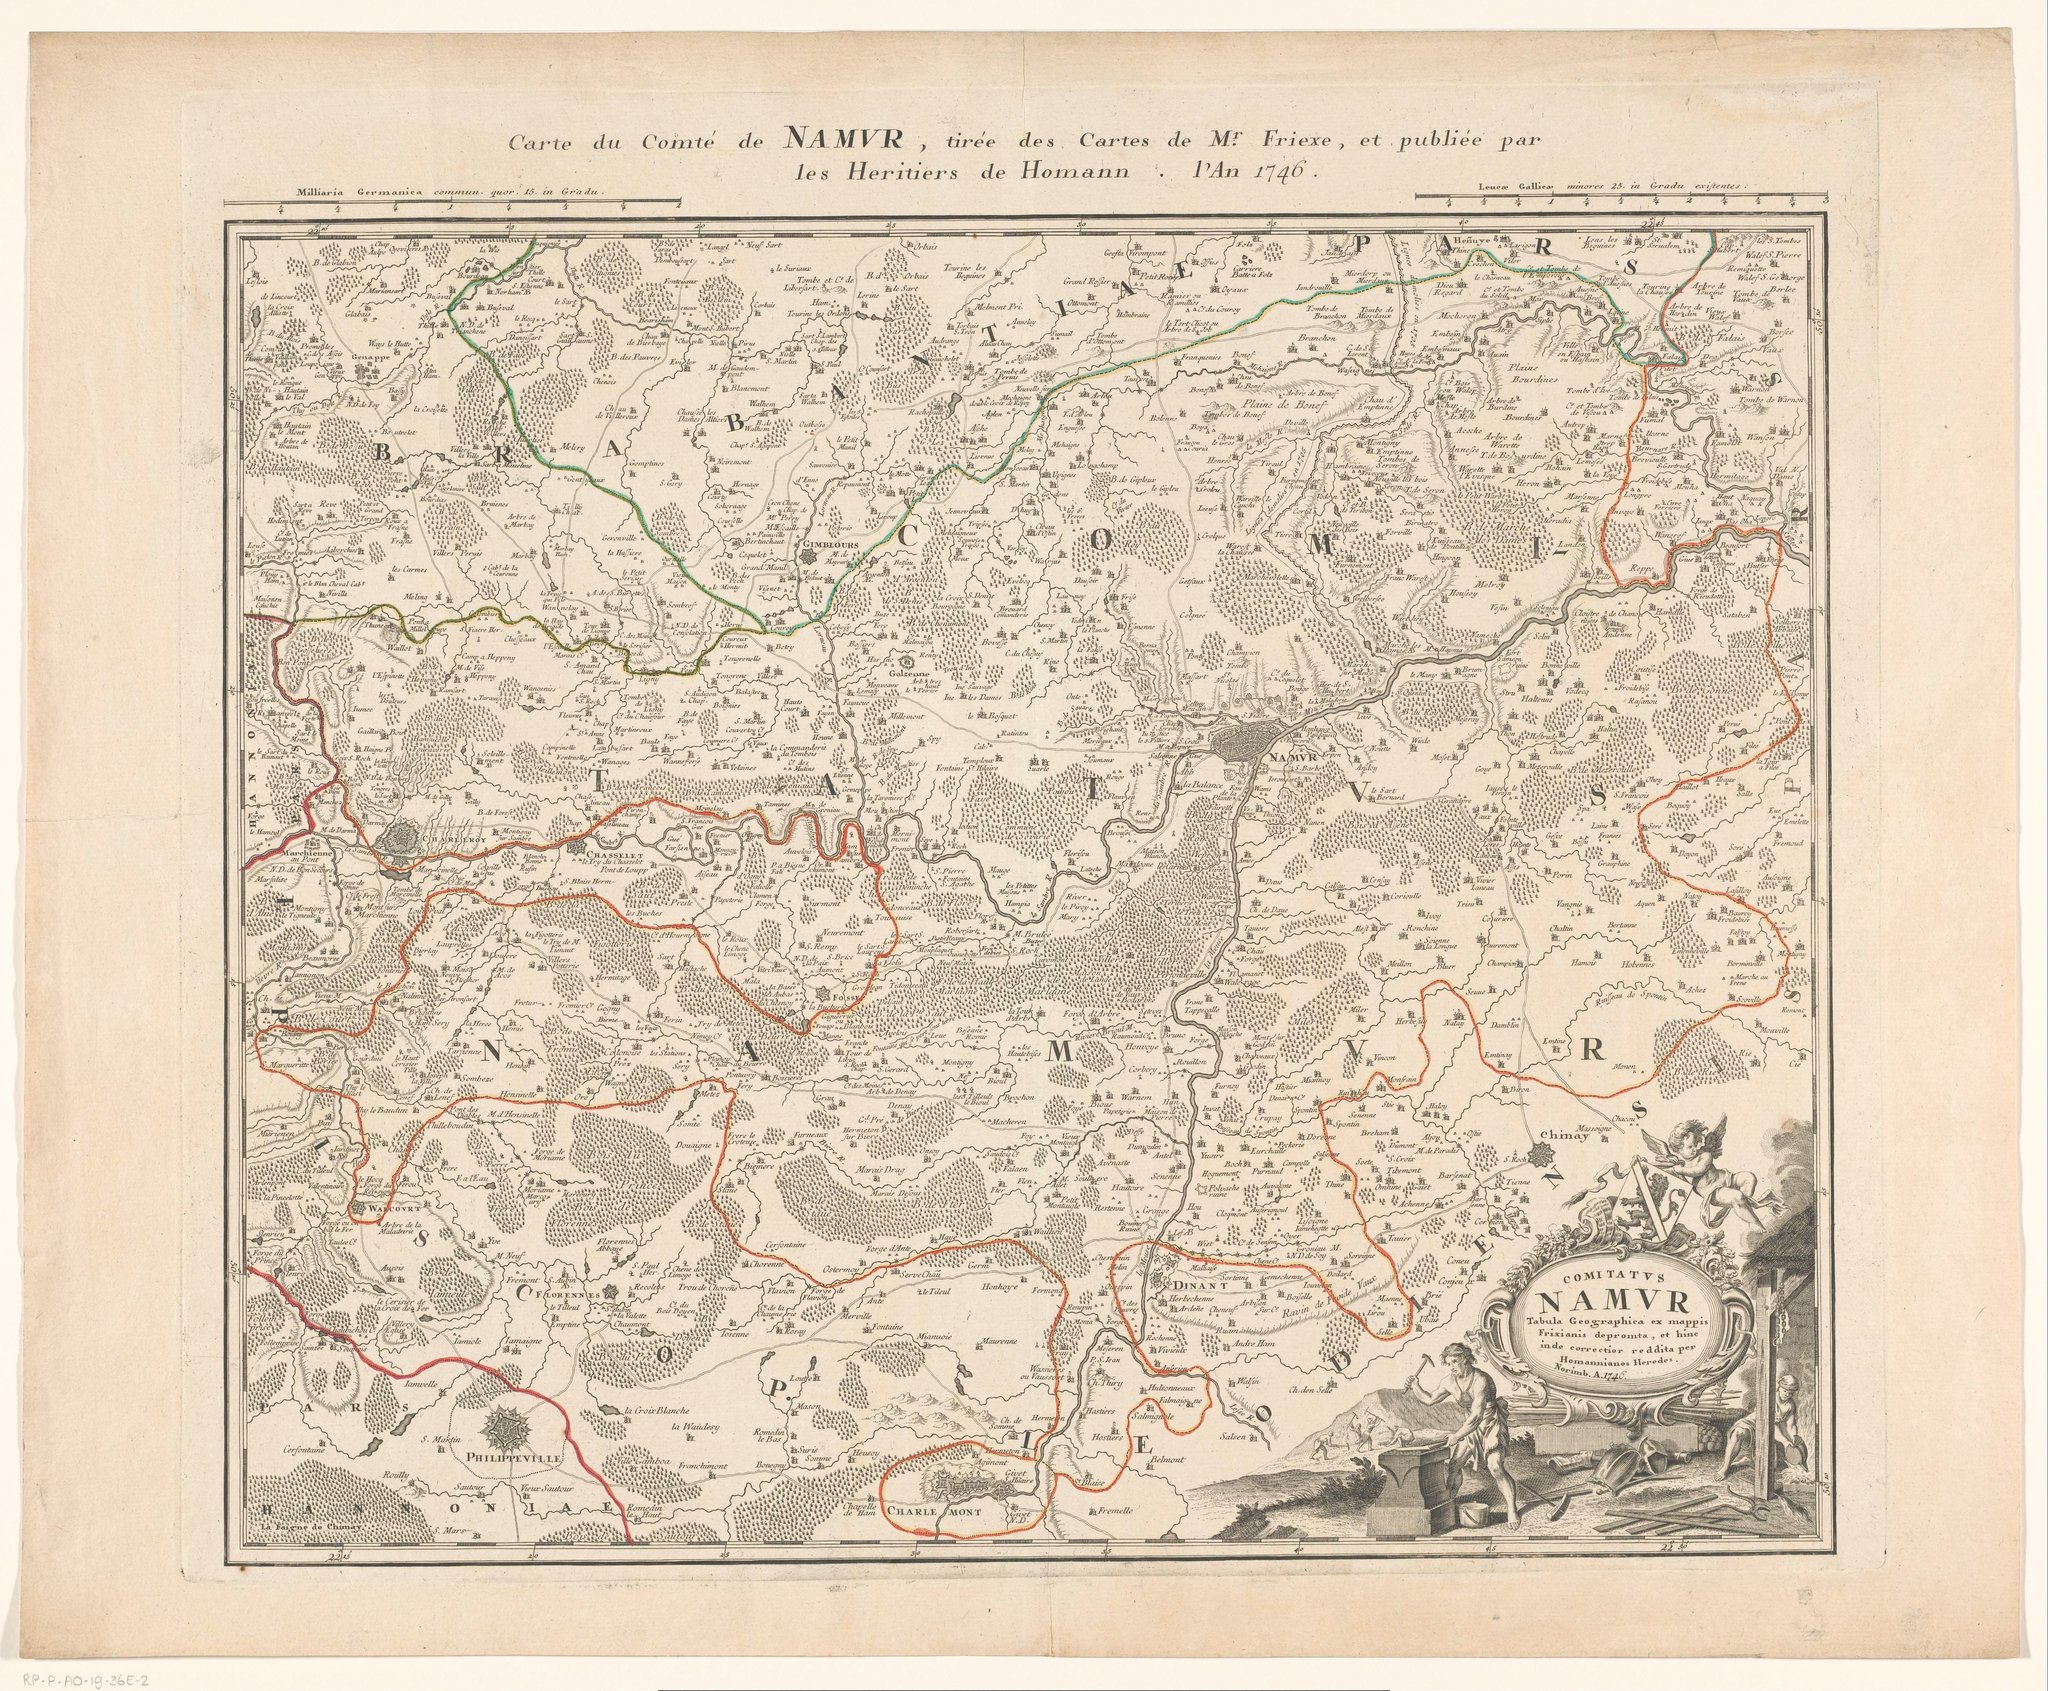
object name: print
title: Carte du comté de Namur, tirée des cartes de mr Friexe (...)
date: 1746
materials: paper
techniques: engraving, etching, hand coloring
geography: nuremberg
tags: maps of separate countries or regions, smith, blacksmith, coat of arms (as symbol of the state, etc.) (+ province; provincial)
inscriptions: collector's mark: Lugt 2228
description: Kaart van het graafschap Namen. Boven de kaart de titel en twee schaalstokken: 2 Milliaria Germanica commun. quor. 15. in Gradu / 3 Leucae Gallicae minores 25. in Gradu existentes. Rechtsonder een titelcartouche met het wapen van het graafschap namen en een voorstelling met een smid in een smederij. De kaart is voorzien van een gradenverdeling langs de randen.